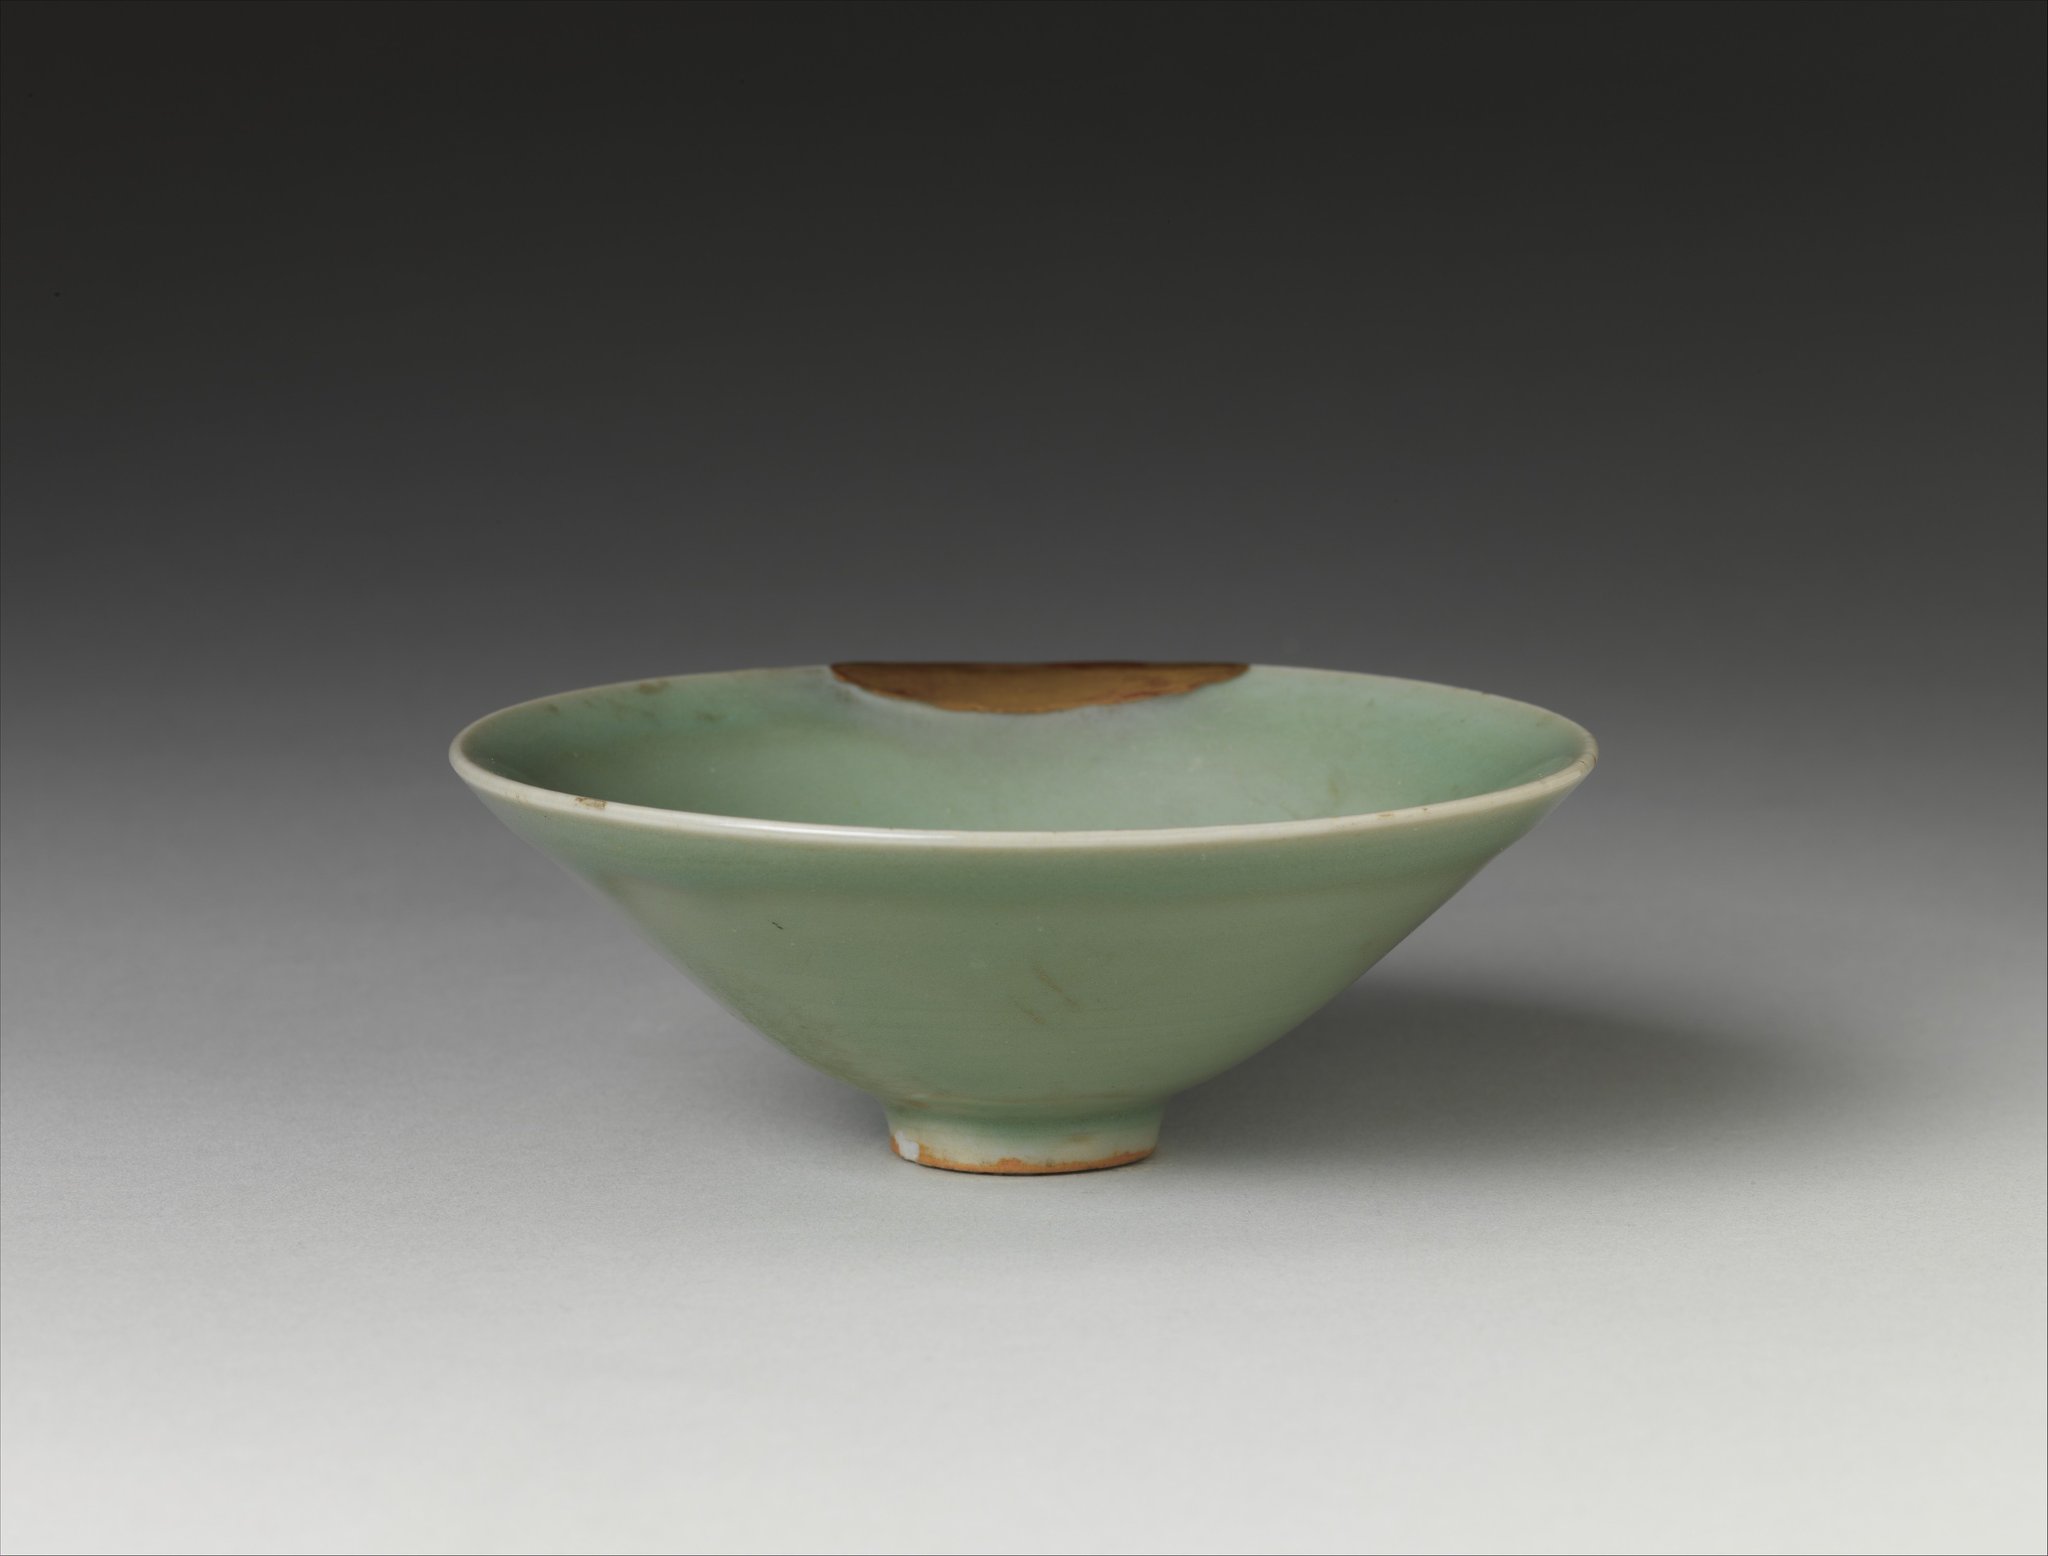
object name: bowl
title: Tea bowl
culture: chinese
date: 1127-1279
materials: ceramic glaze, glaze, gold, lacquer, stoneware